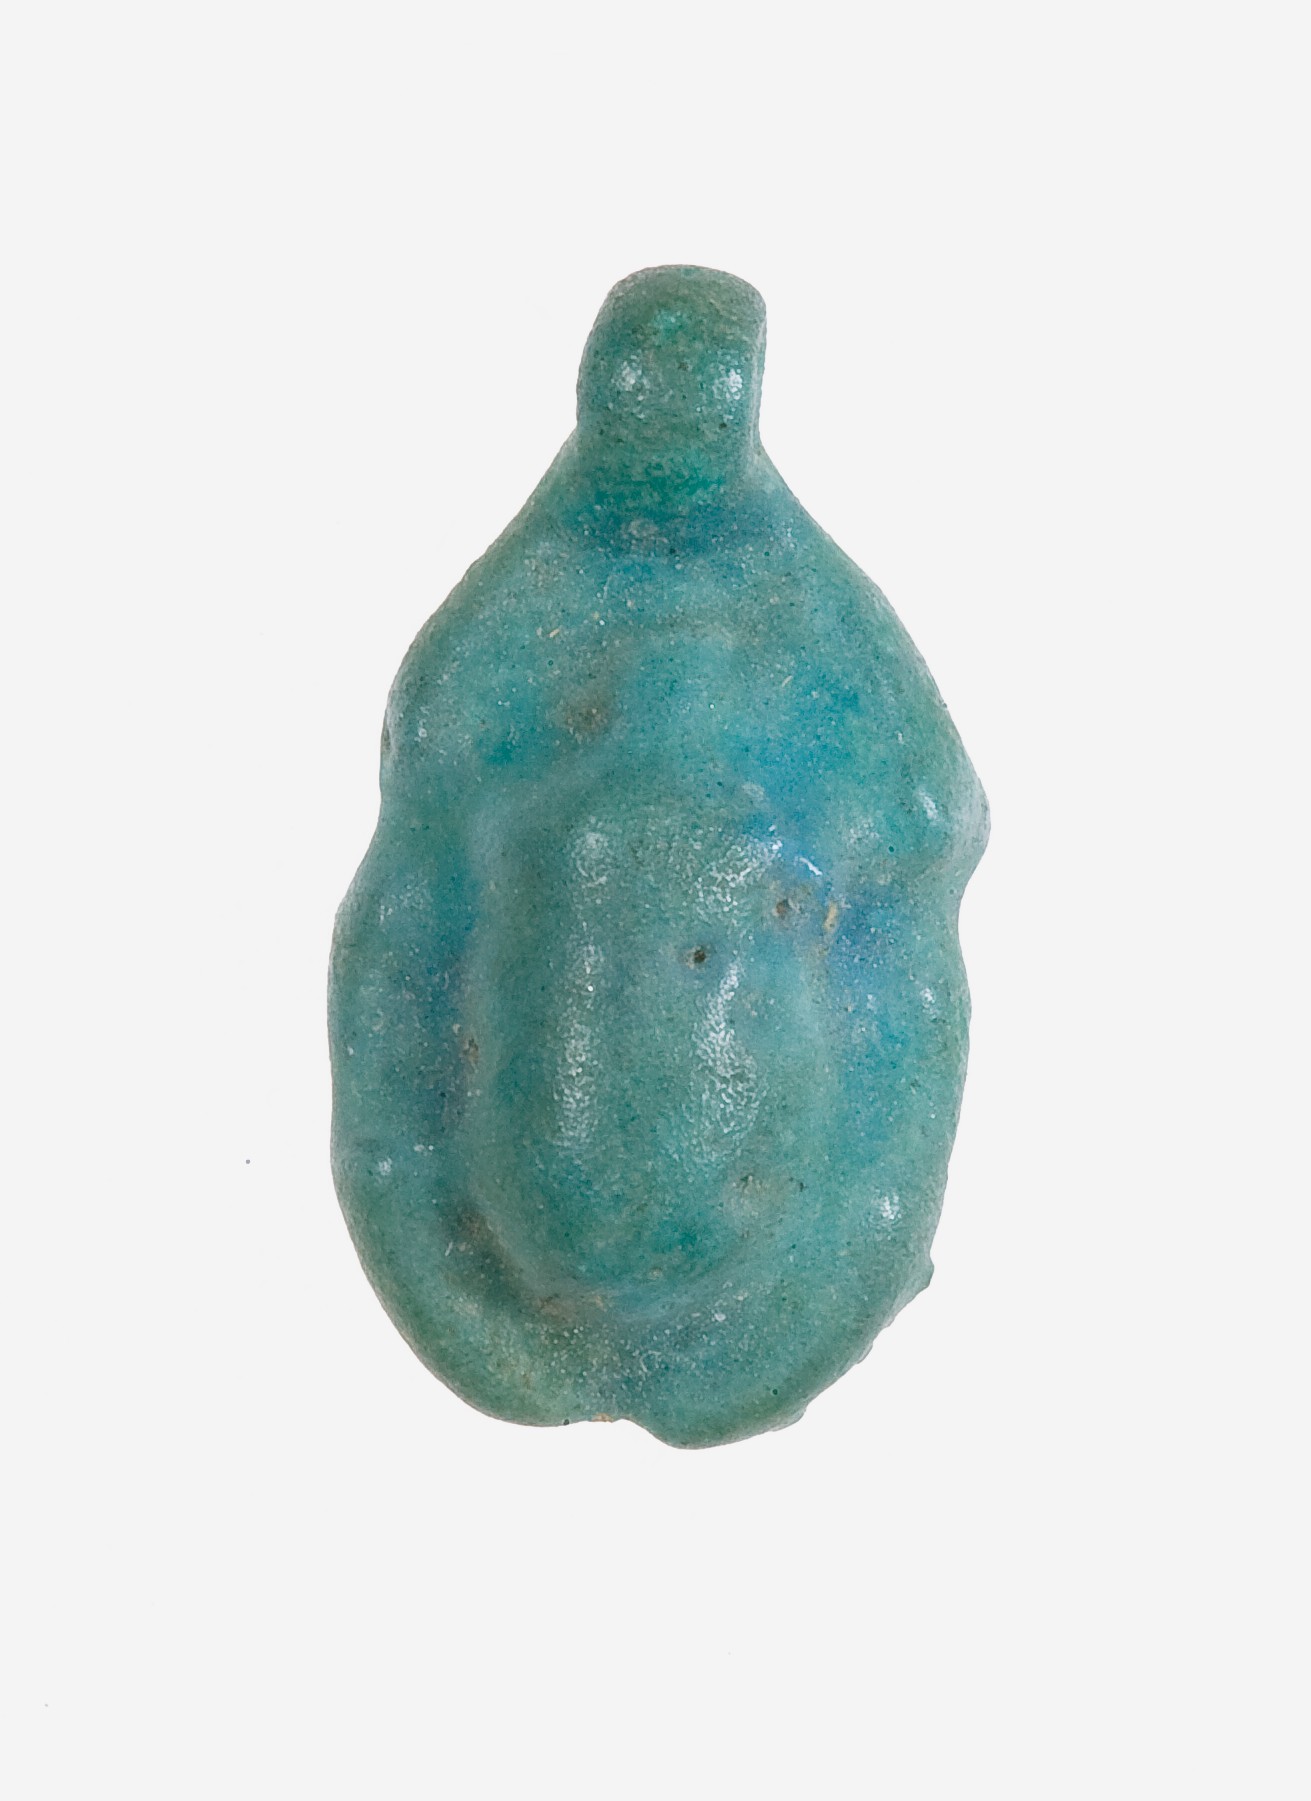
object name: pendant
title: Scarab pendant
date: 1390-1352 BCE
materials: faience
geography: egypt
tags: scarabs